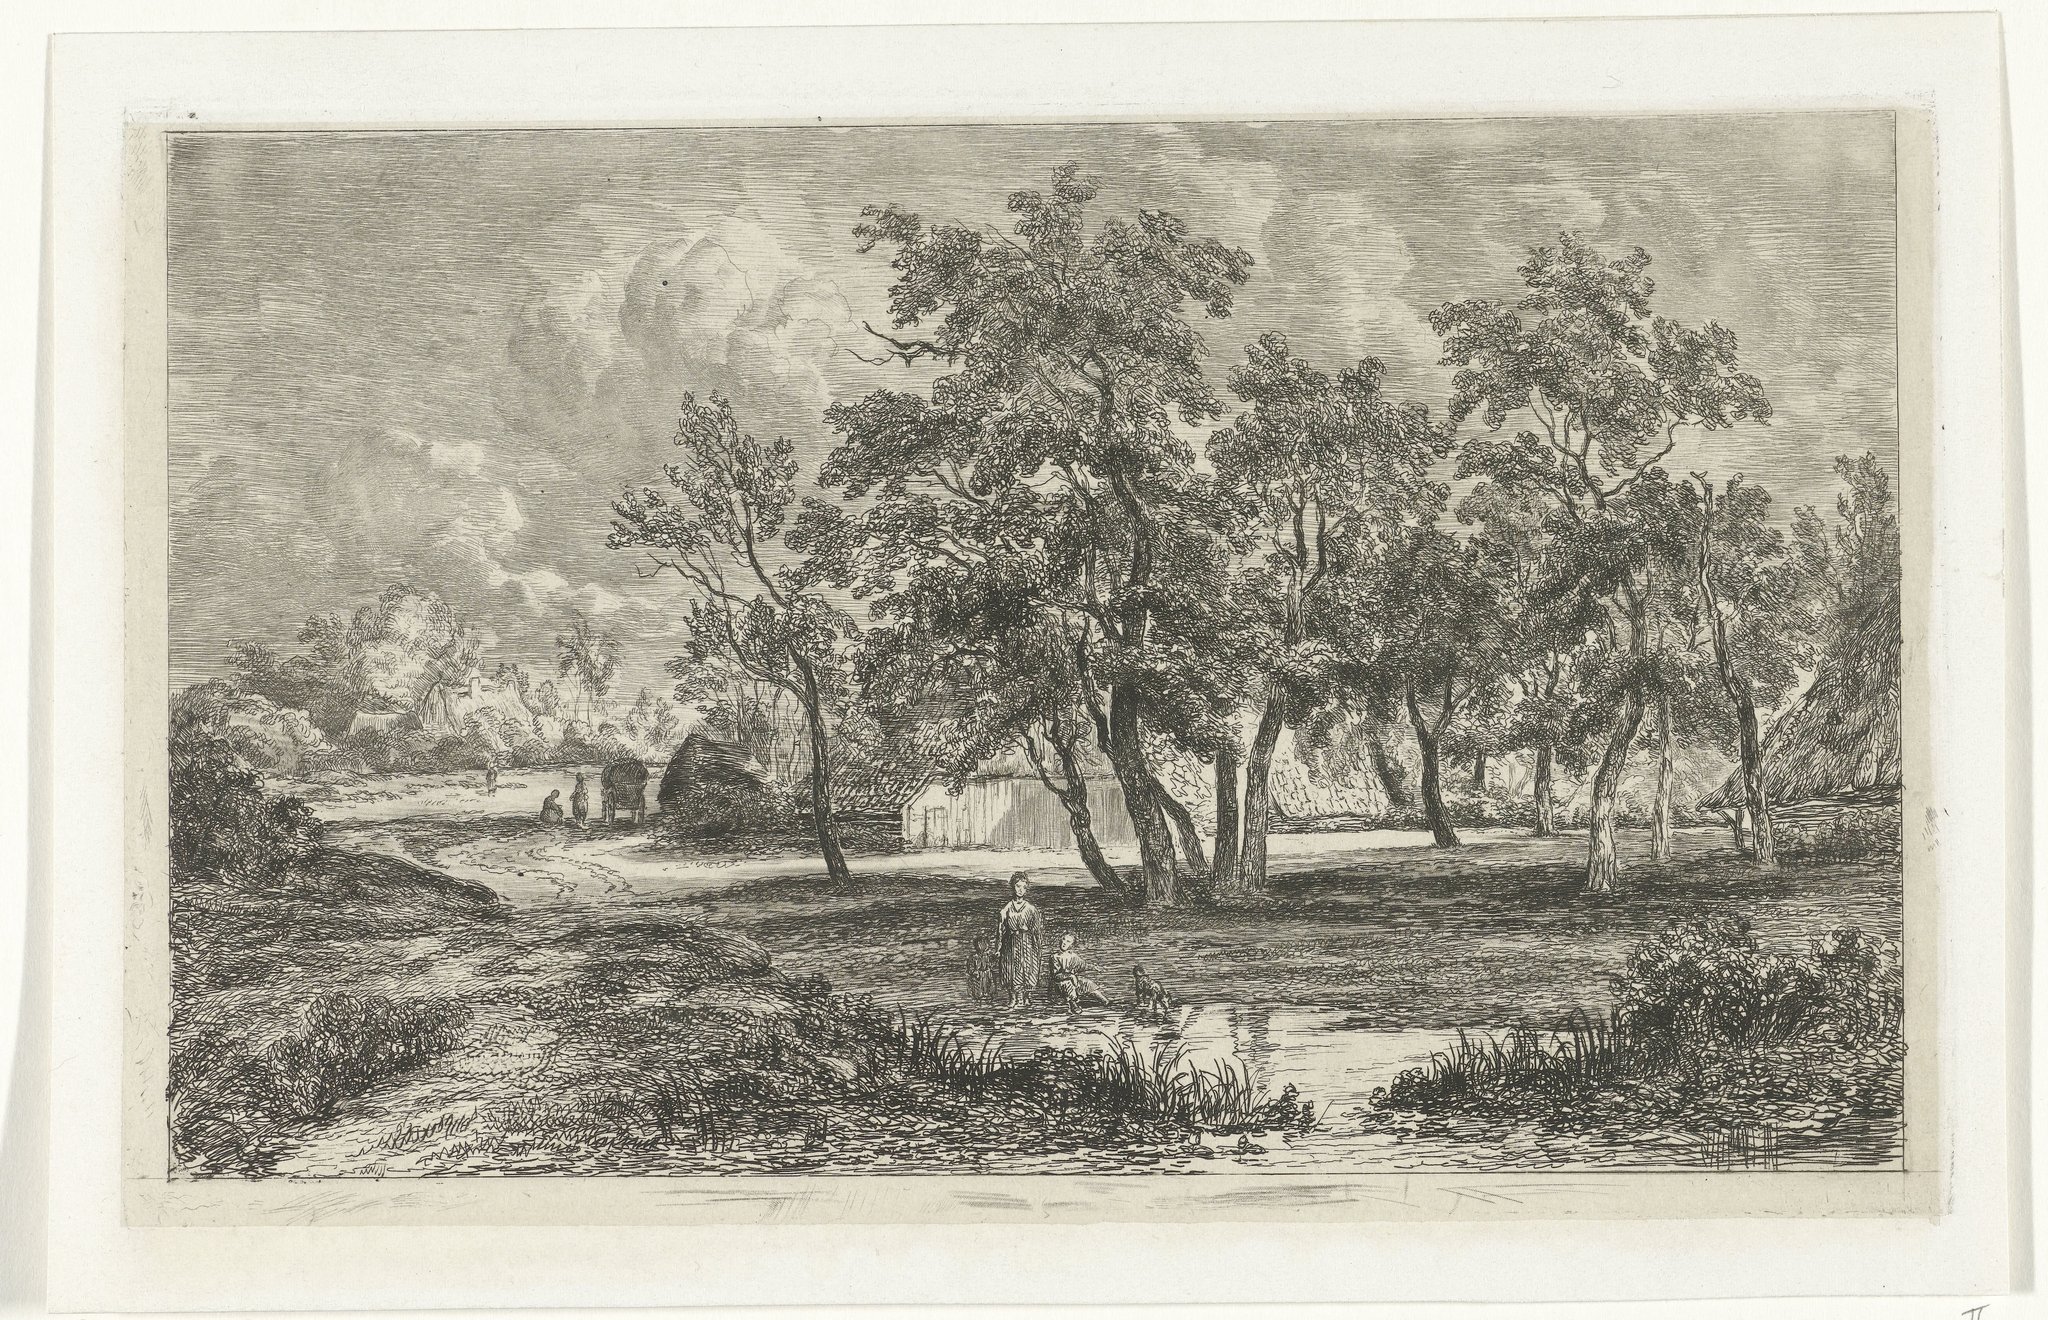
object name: print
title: Landschap met boerderij tussen de bomen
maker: christiaan immerzeel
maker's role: print maker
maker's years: 1808-1886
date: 1818-1886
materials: paper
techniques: etching, roulette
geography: netherlands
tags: landscapes (+ landscape with figures, staffage), farm or solitary house in landscape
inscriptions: collector's mark: Lugt 2760, collector's mark: Lugt 2228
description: Landschap met drie figuren en een hond bij een waterplas. Daarachter ligt een boerderij tussen de bomen. Links een weg met figuren en een kar.